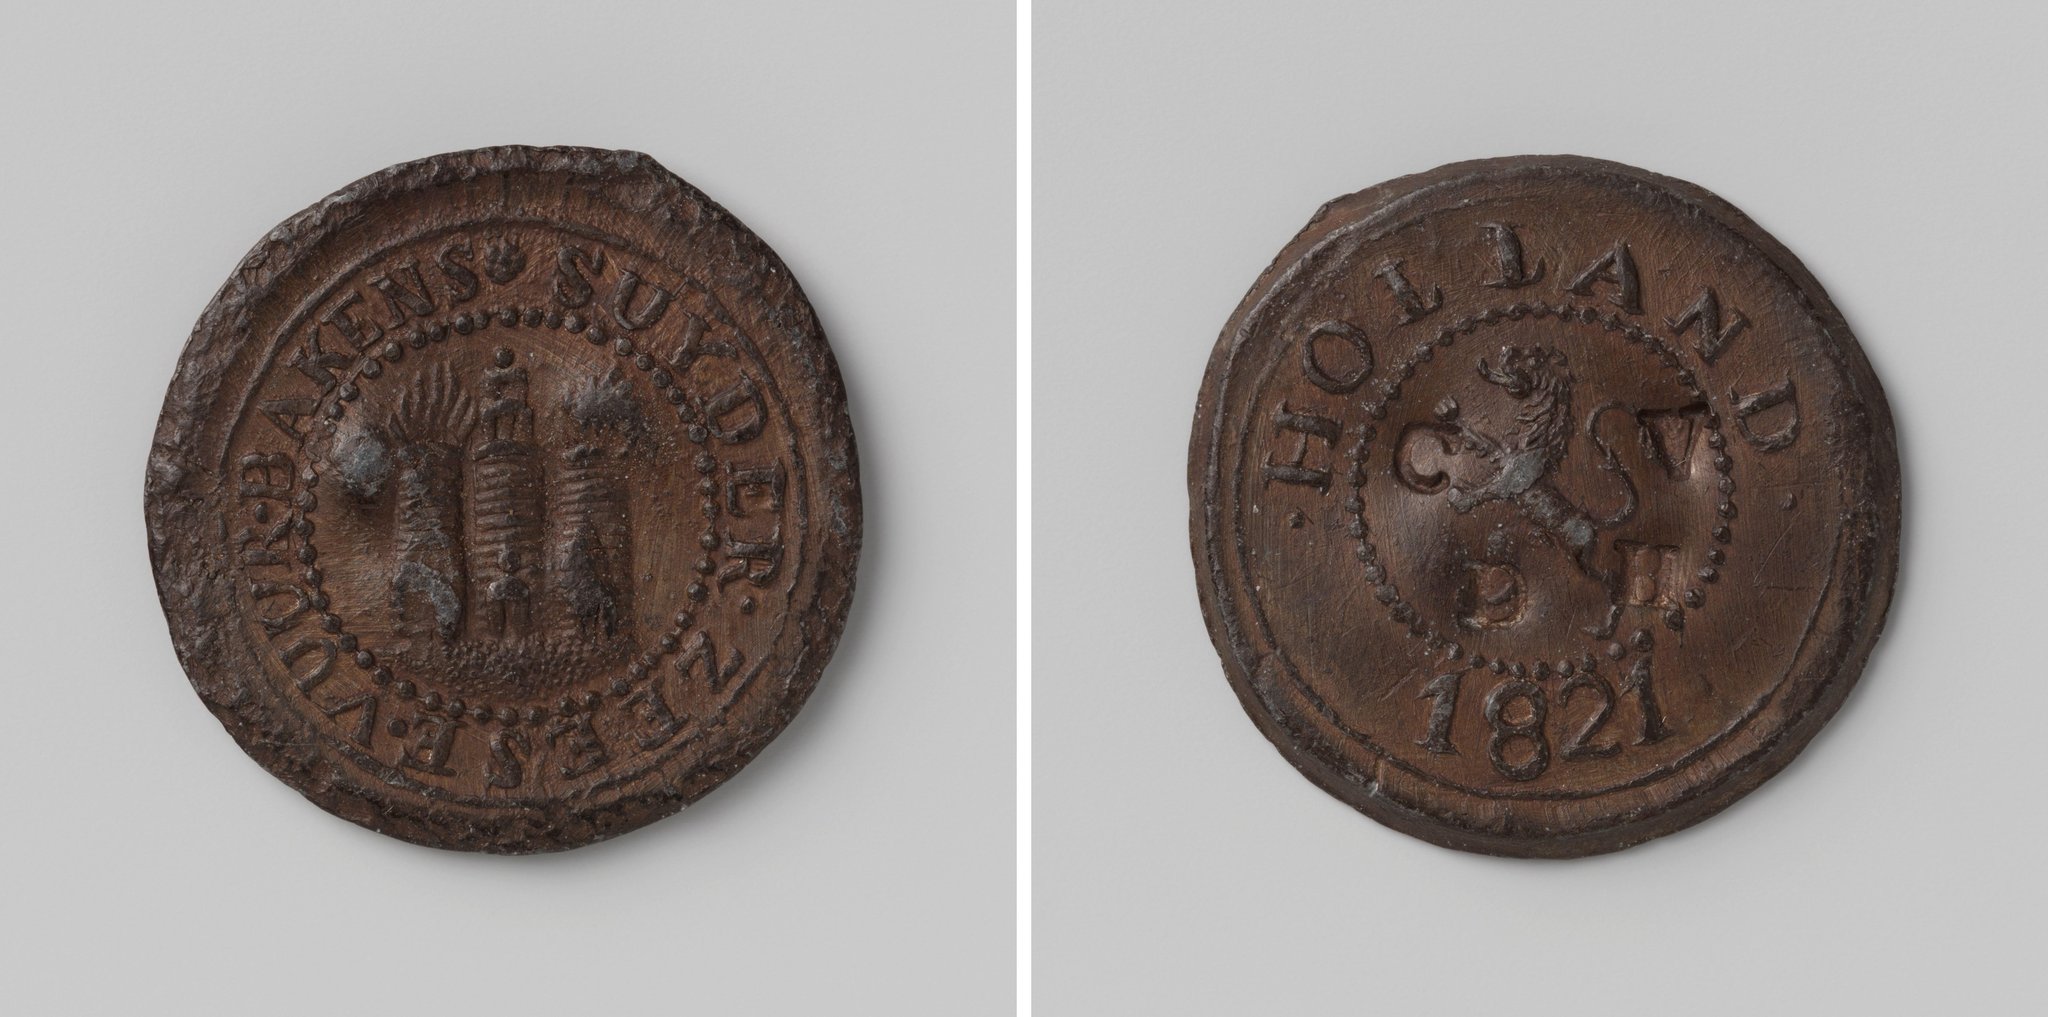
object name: tax token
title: Vuurbakens van Amsterdam aan de Zuiderzee, voor schepen onder de vijftig last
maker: Anonymous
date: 1821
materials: copper, lead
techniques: striking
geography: netherlands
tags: amsterdam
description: Voorzijde: drie vuurbakens, waarvan linker en rechter branden binnen omschrift; vier kloppen: letters C, V, D en H. Keerzijde: leeuw onder wapenschild van Amsterdam binnen omschrift